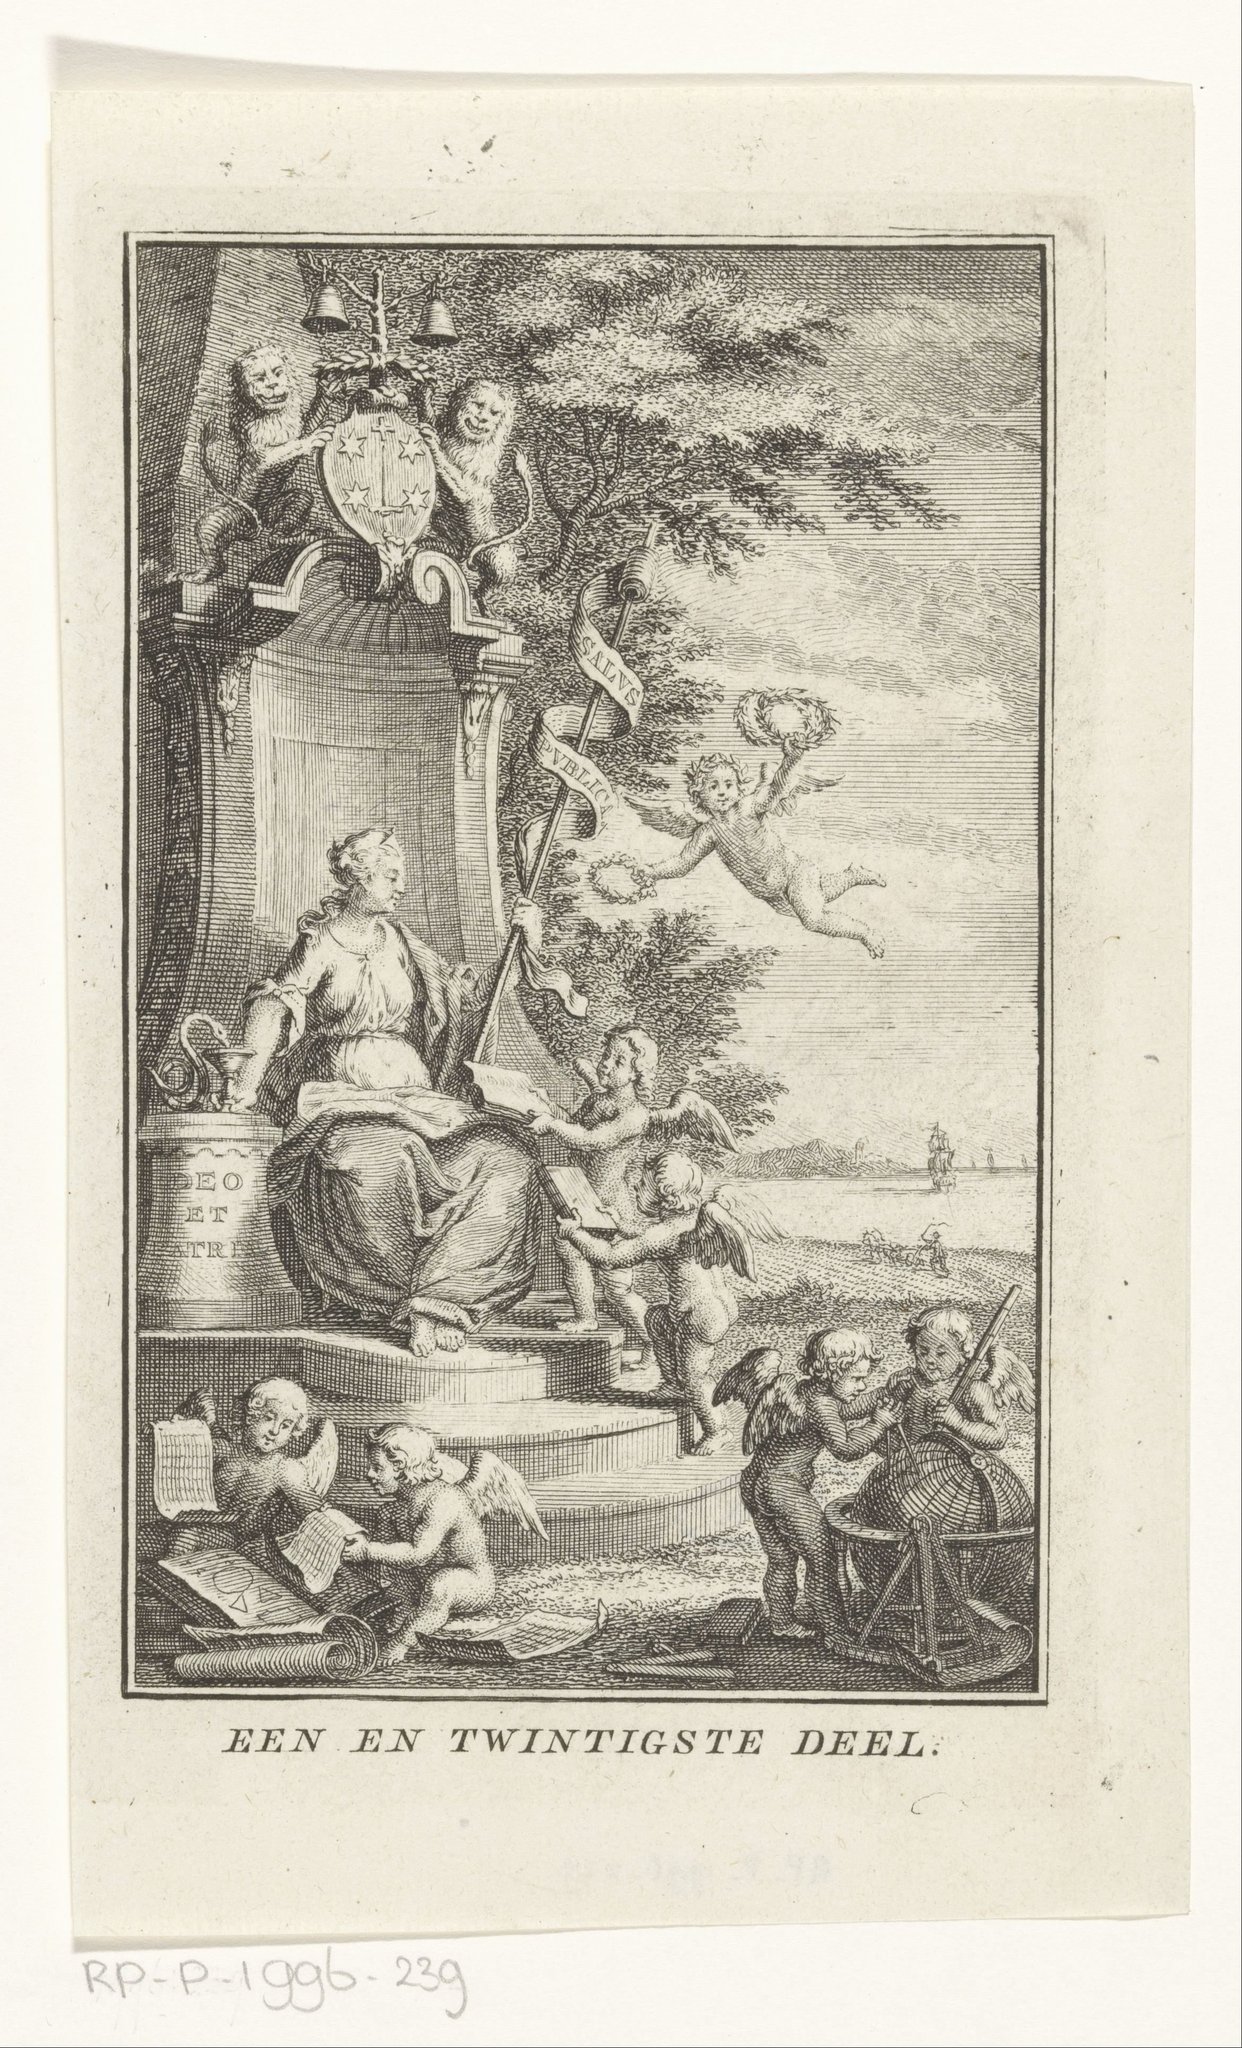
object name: print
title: Stedenmaagd van Haarlem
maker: jacob folkema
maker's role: draughtsman, print maker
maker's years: 1692-1767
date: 1702-1767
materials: paper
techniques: engraving, etching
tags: sailing-ship, sailing-boat, symbolic representations, allegories and emblems ~ science, 'scientia'; 'scienza', 'studio' (ripa), personification of a city, town-patron(ess), cupids: 'amores', 'amoretti', 'putti', haarlem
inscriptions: collector's mark: Lugt 2760, collector's mark: Lugt 2228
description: De stedenmaagd van Haarlem zit onder het wapen van Haarlem met een staf met banderol in haar handen. Op de banderol staat: Salus Publica, algemeen welzijn. Zij laat haar hand rusten op een voetstuk met de woorden: Deo et Patriae. Voor de troon putti met papieren en boeken, passer en meetlat en een globe. Allegorische voorstelling waarin de stad Haarlem als bevorderaar van de wetenschap en de kunsten wordt voorgesteld.